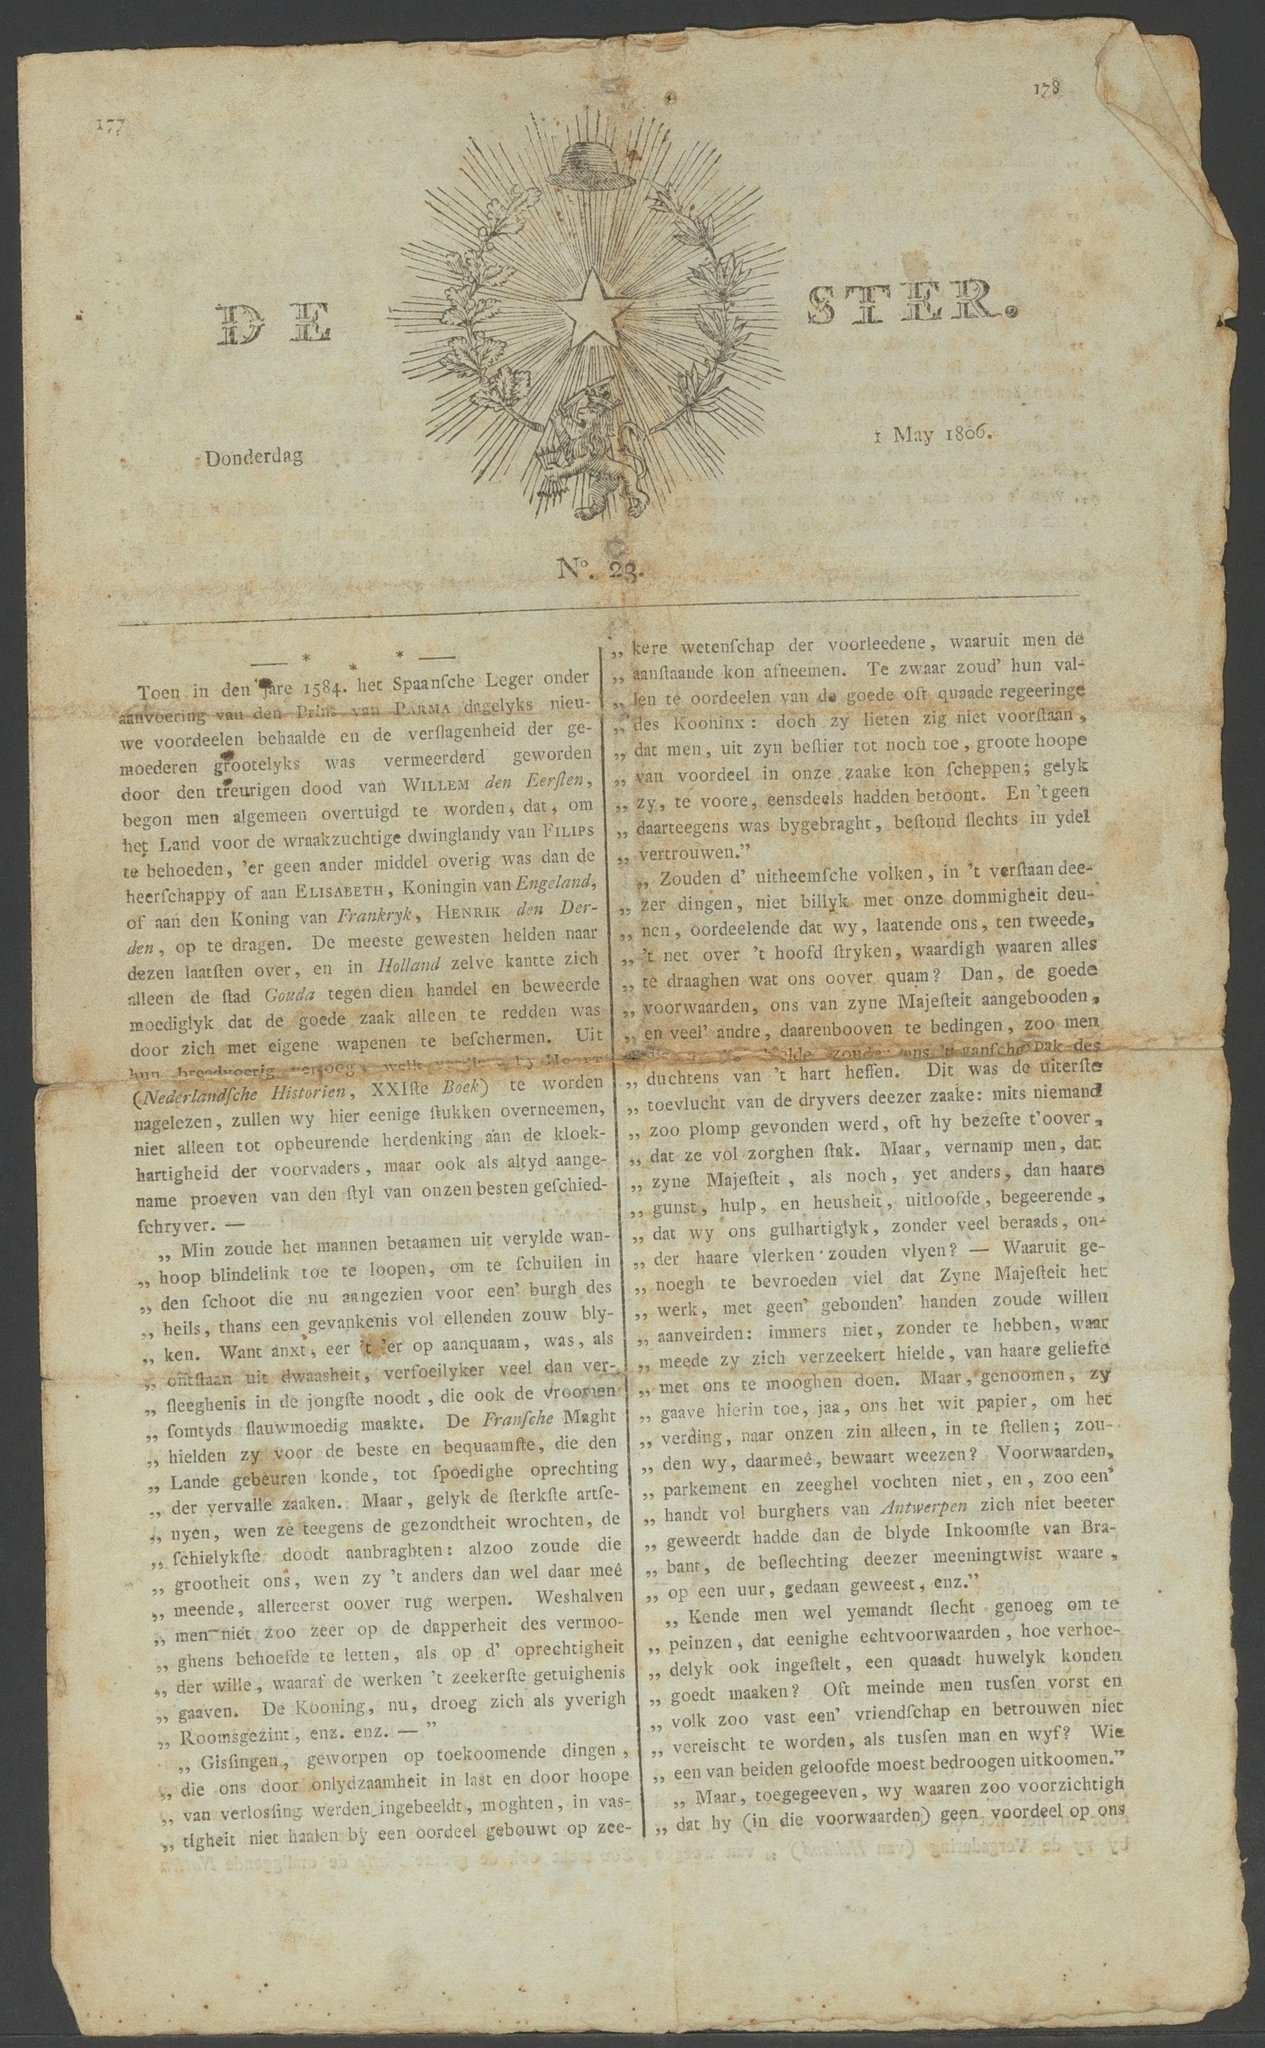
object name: newspaper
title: De Ster, 1 mei 1806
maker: Anonymous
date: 1806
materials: paper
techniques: letterpress printing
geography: netherlands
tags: newspaper, news-sheet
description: Exemplaar van de krant 'De Ster' van 1 mei 1806, nr. 23. Dubbelbladig, alle zijden bedrukt. De kolommen genummerd 177-184. Bovenaan een vignet met een stralende ster. Onderwerpsrubrieken binnen de Atlas Zeden en Gewoonten: Regeering, Officieele Nieuwsbladen.